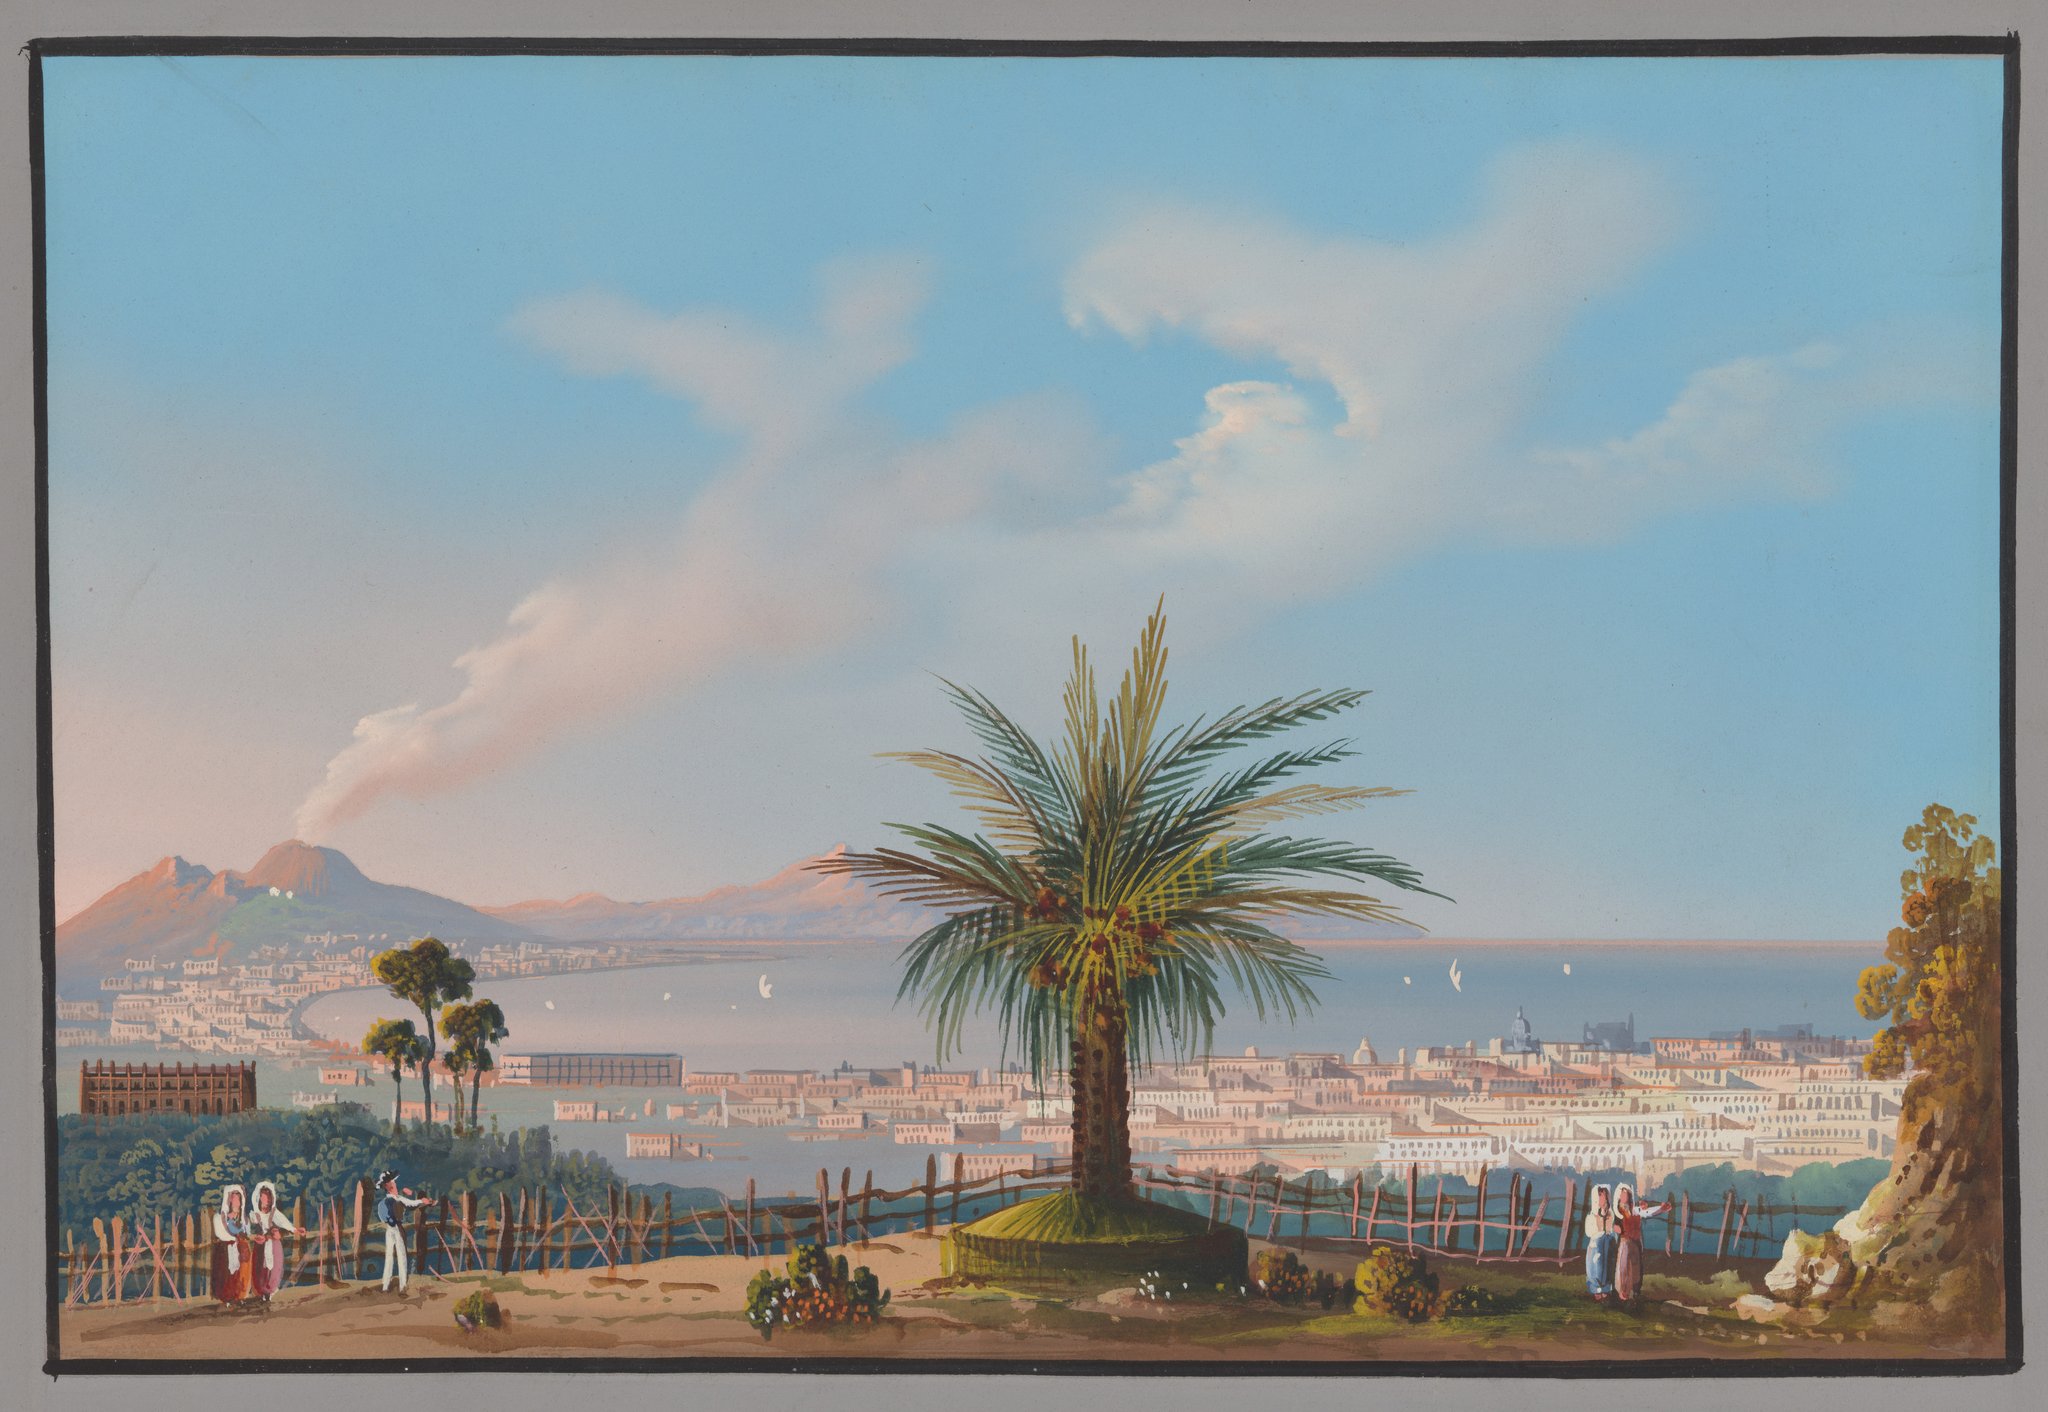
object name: drawing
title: View of Naples from San Martino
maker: italian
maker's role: artist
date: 1810-1840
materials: gouache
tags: towns,landscapes